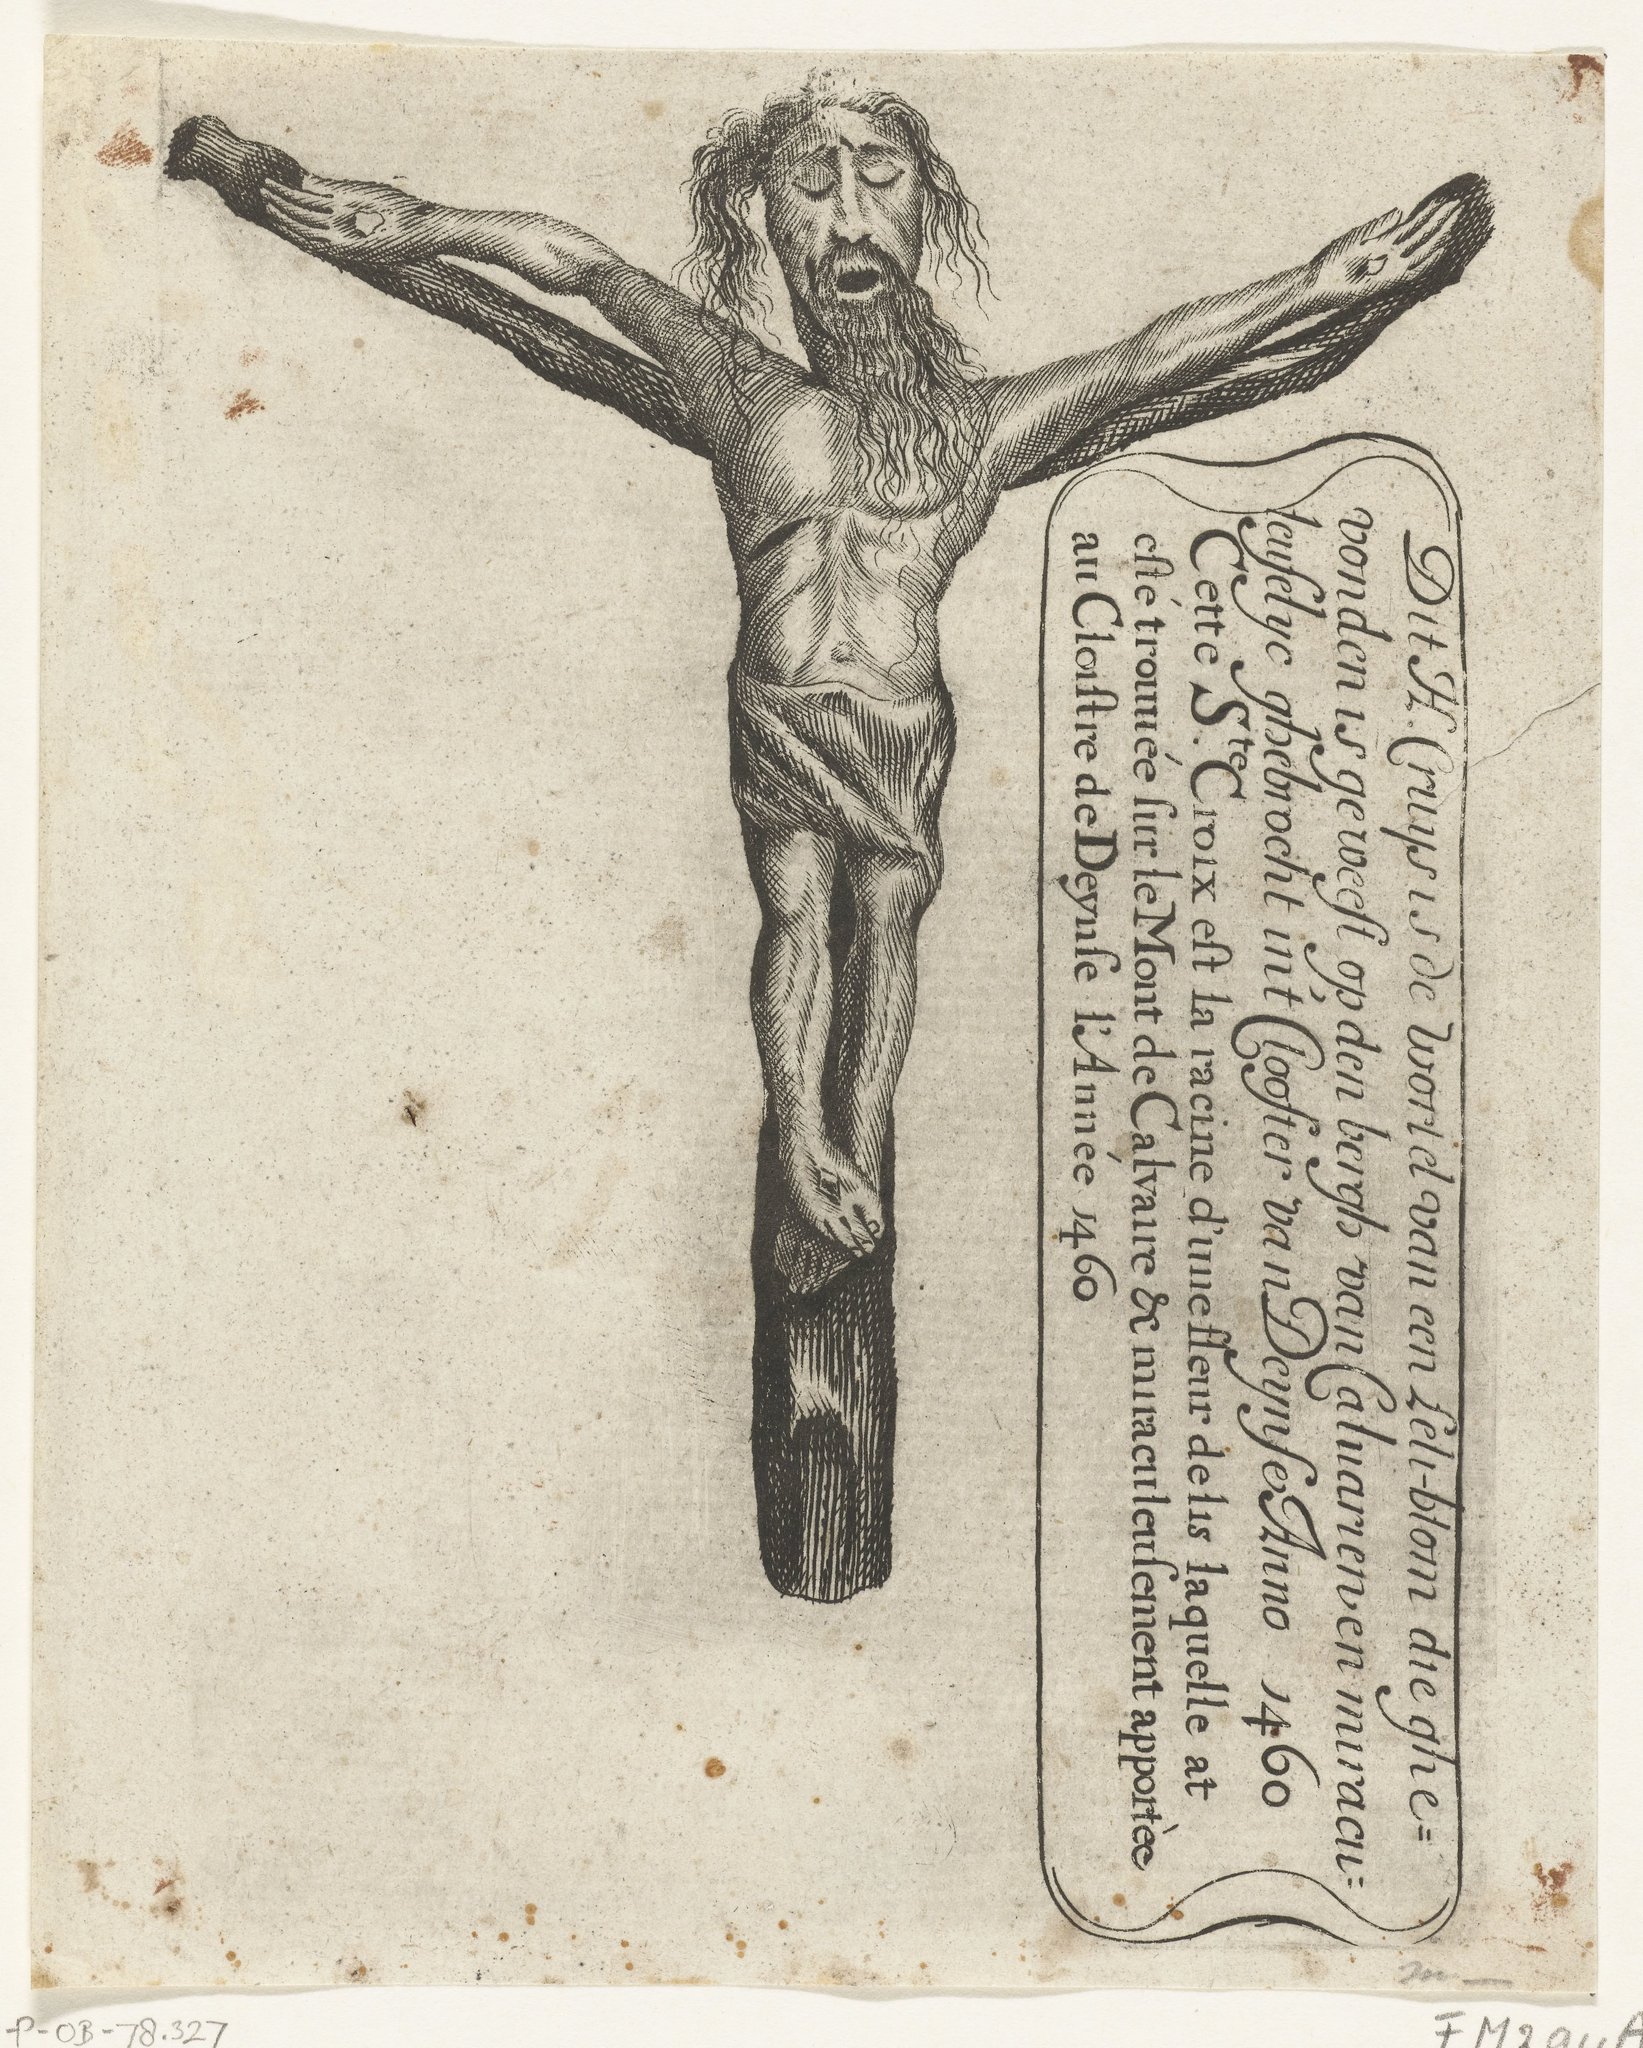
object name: historical object representation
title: Dit H. Cruys is de wortel van een Leli-blom die ghevonden is geweest op den bergh van Calvarien en Miraculeuselyc ghebrocht in't Clooster van Deynse Anno 1460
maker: Anonymous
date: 1600-1699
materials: paper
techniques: engraving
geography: low countries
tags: crucifix ~ personal devotion, burgundian netherlands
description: Wortel van een lelie gevonden op Calvarieberg die de vorm heeft van een kruisbeeld, bewaard in het klooster van Deinze, 1460